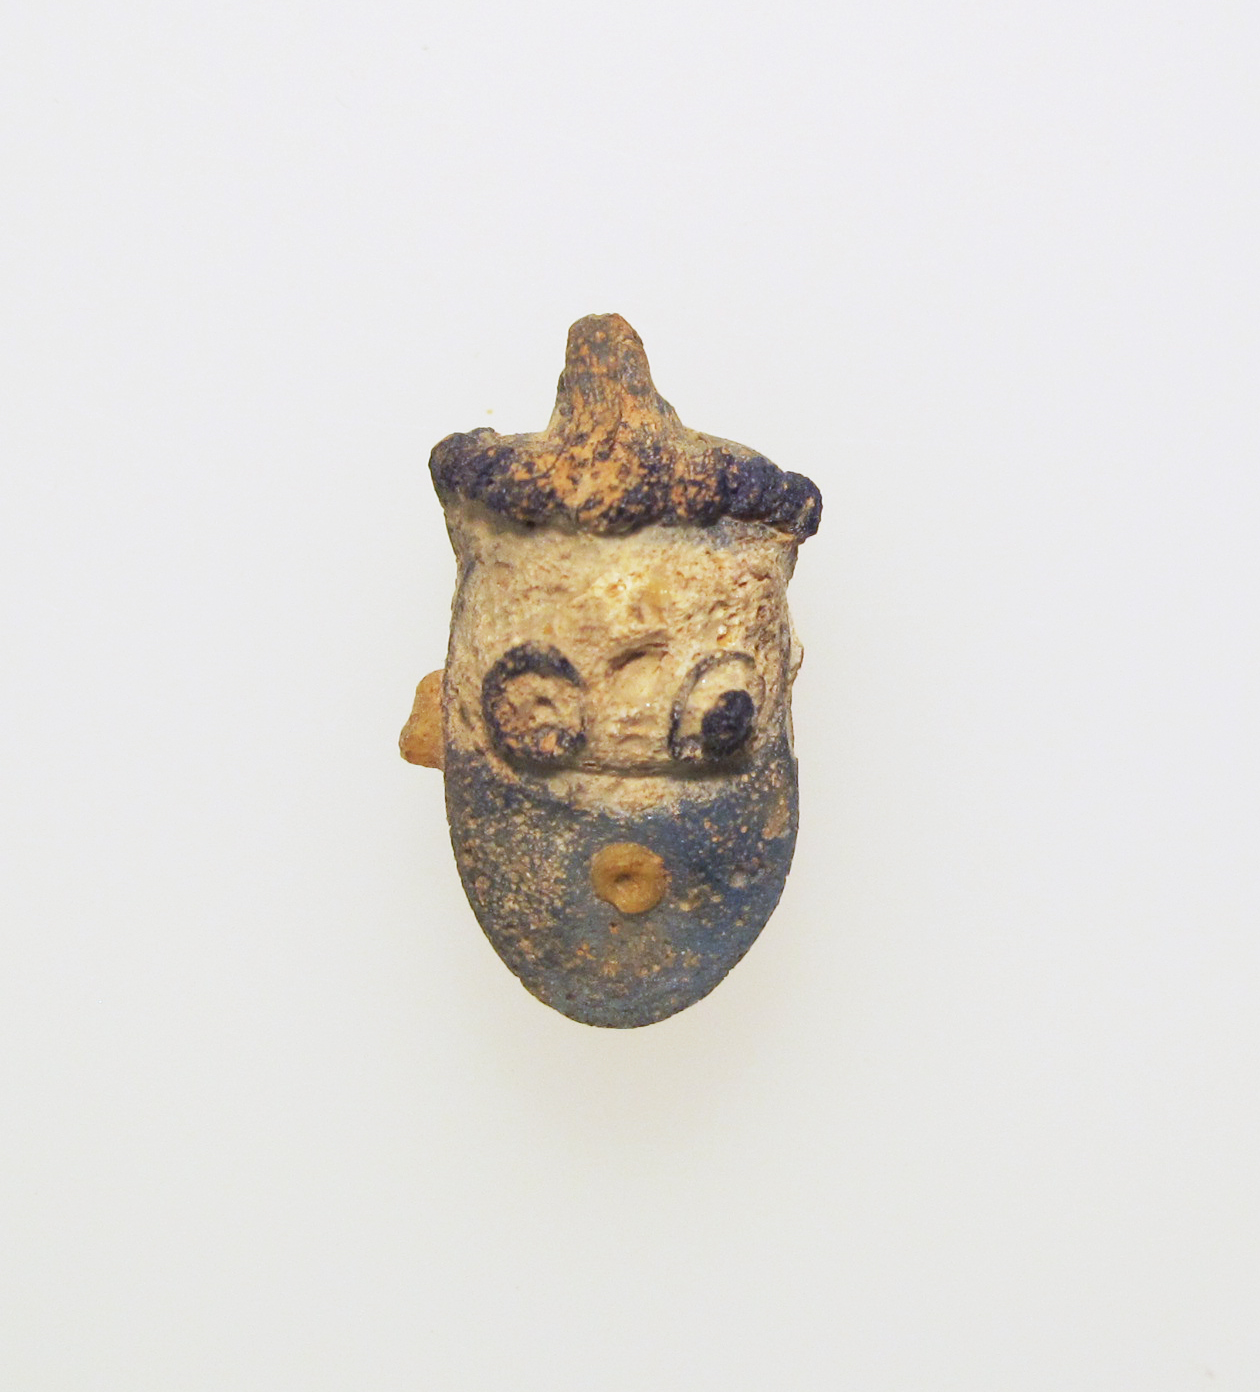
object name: head pendant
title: Glass head pendant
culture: phoenician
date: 467-301 BCE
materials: glass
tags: heads